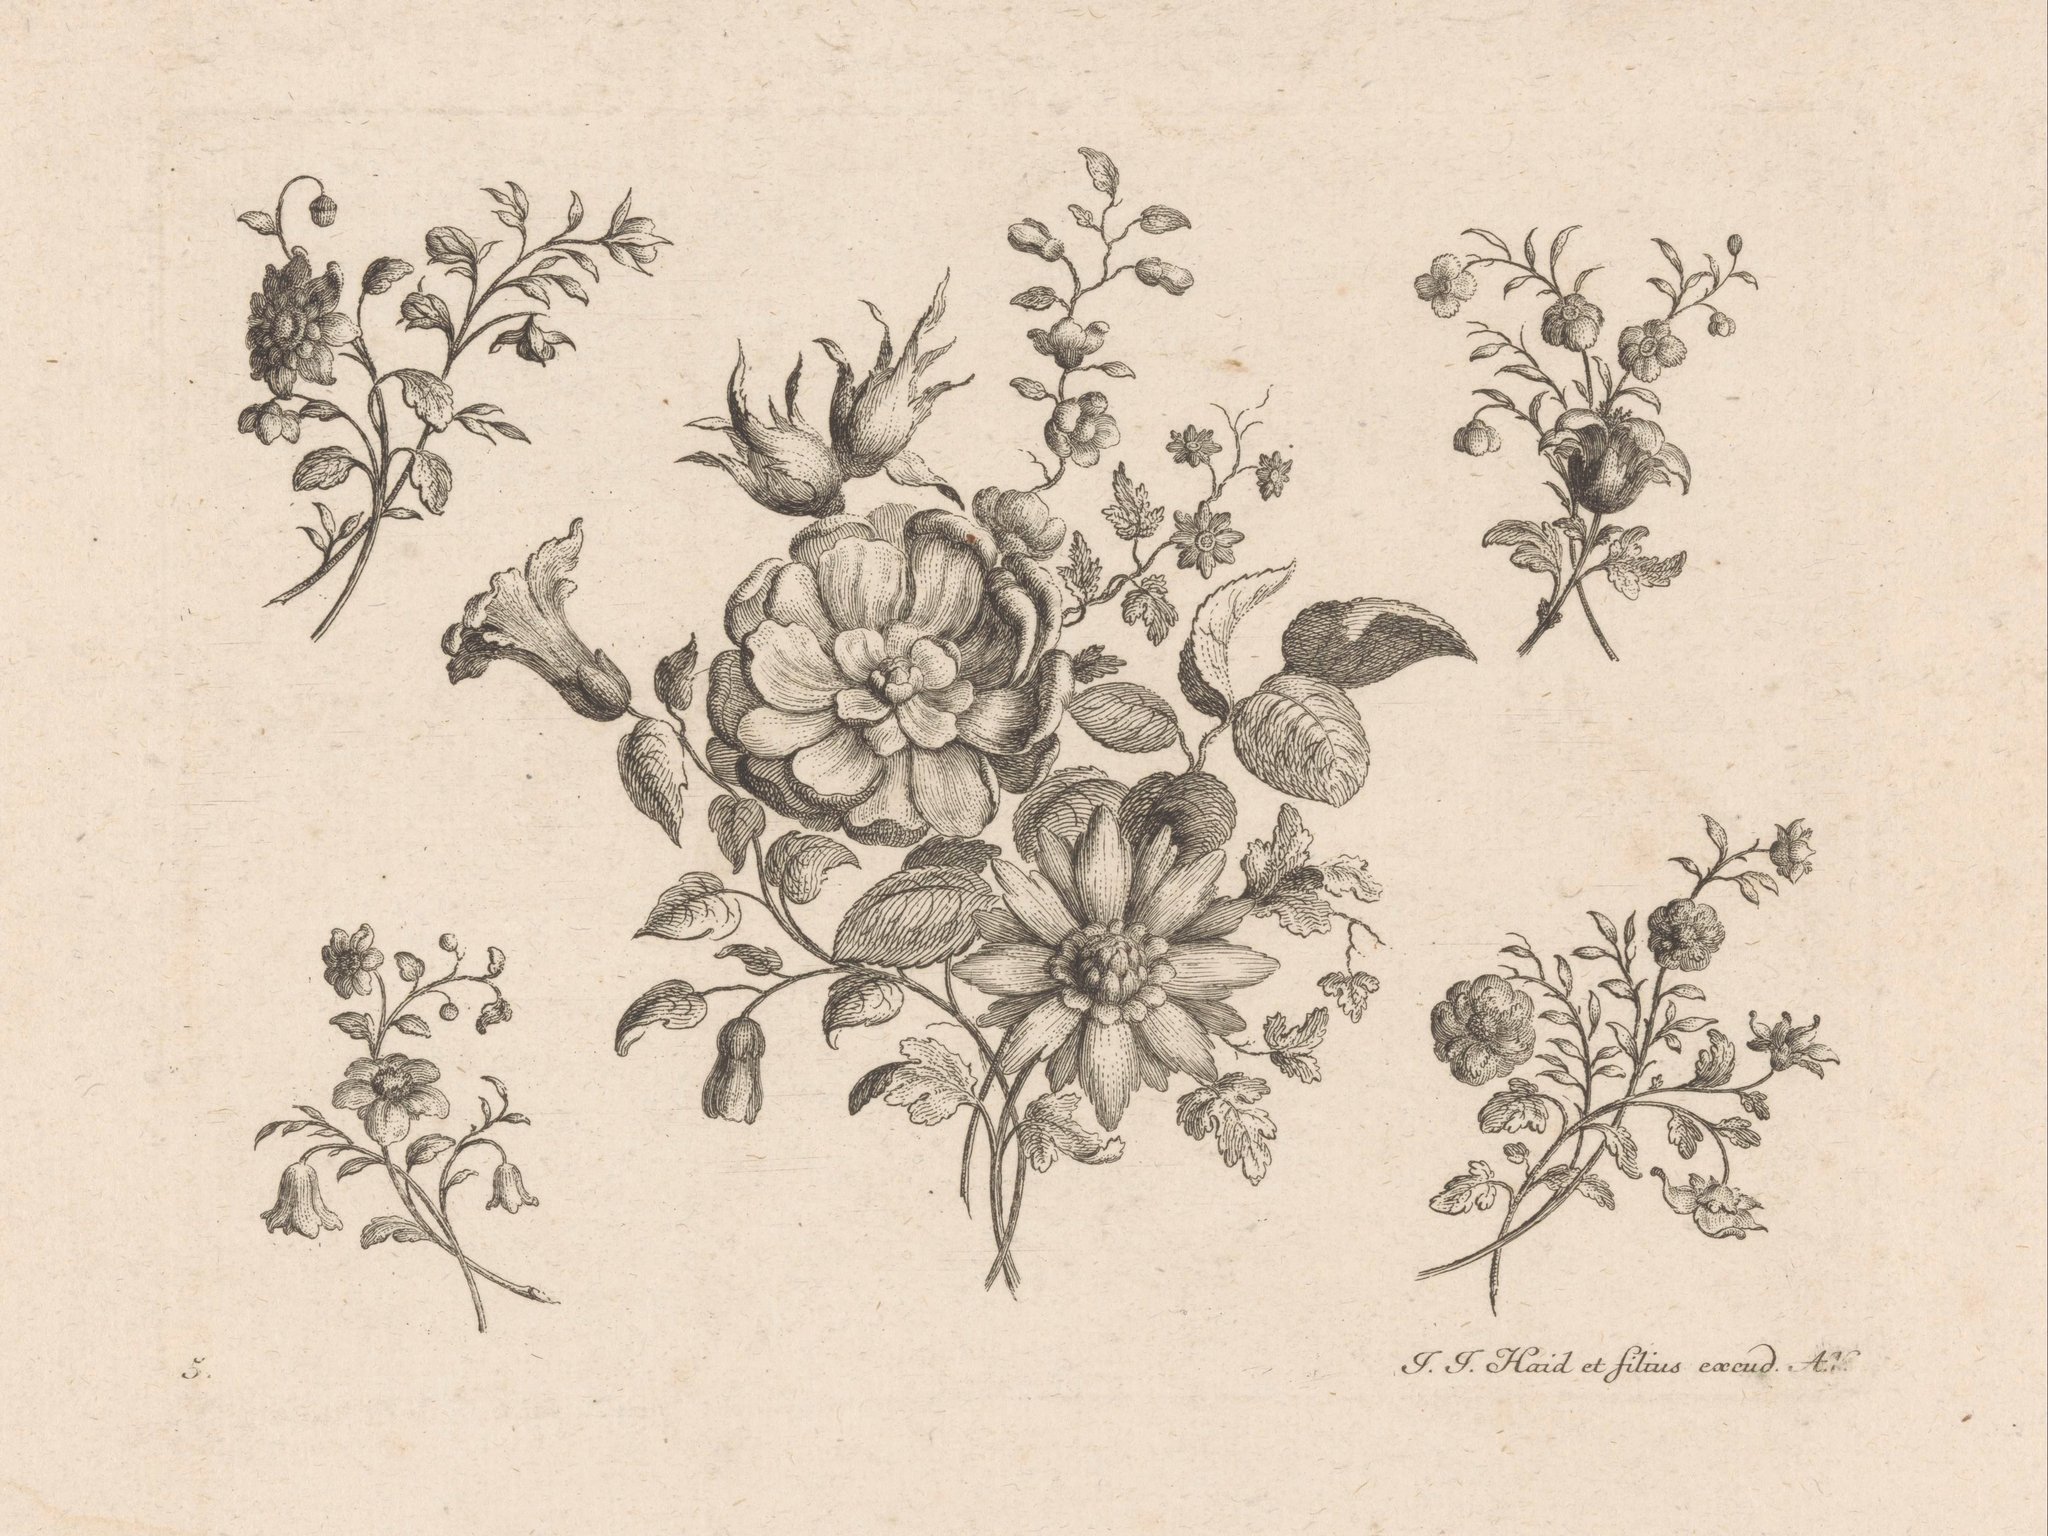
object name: print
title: Bloemen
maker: Anonymous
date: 1749-1767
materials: paper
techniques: etching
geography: augsburg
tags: cut flowers; nosegay, bunch of flowers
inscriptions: collector's mark: Lugt 2228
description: Een bos bloemen in het midden, omringd door bloemen in de vier hoeken.